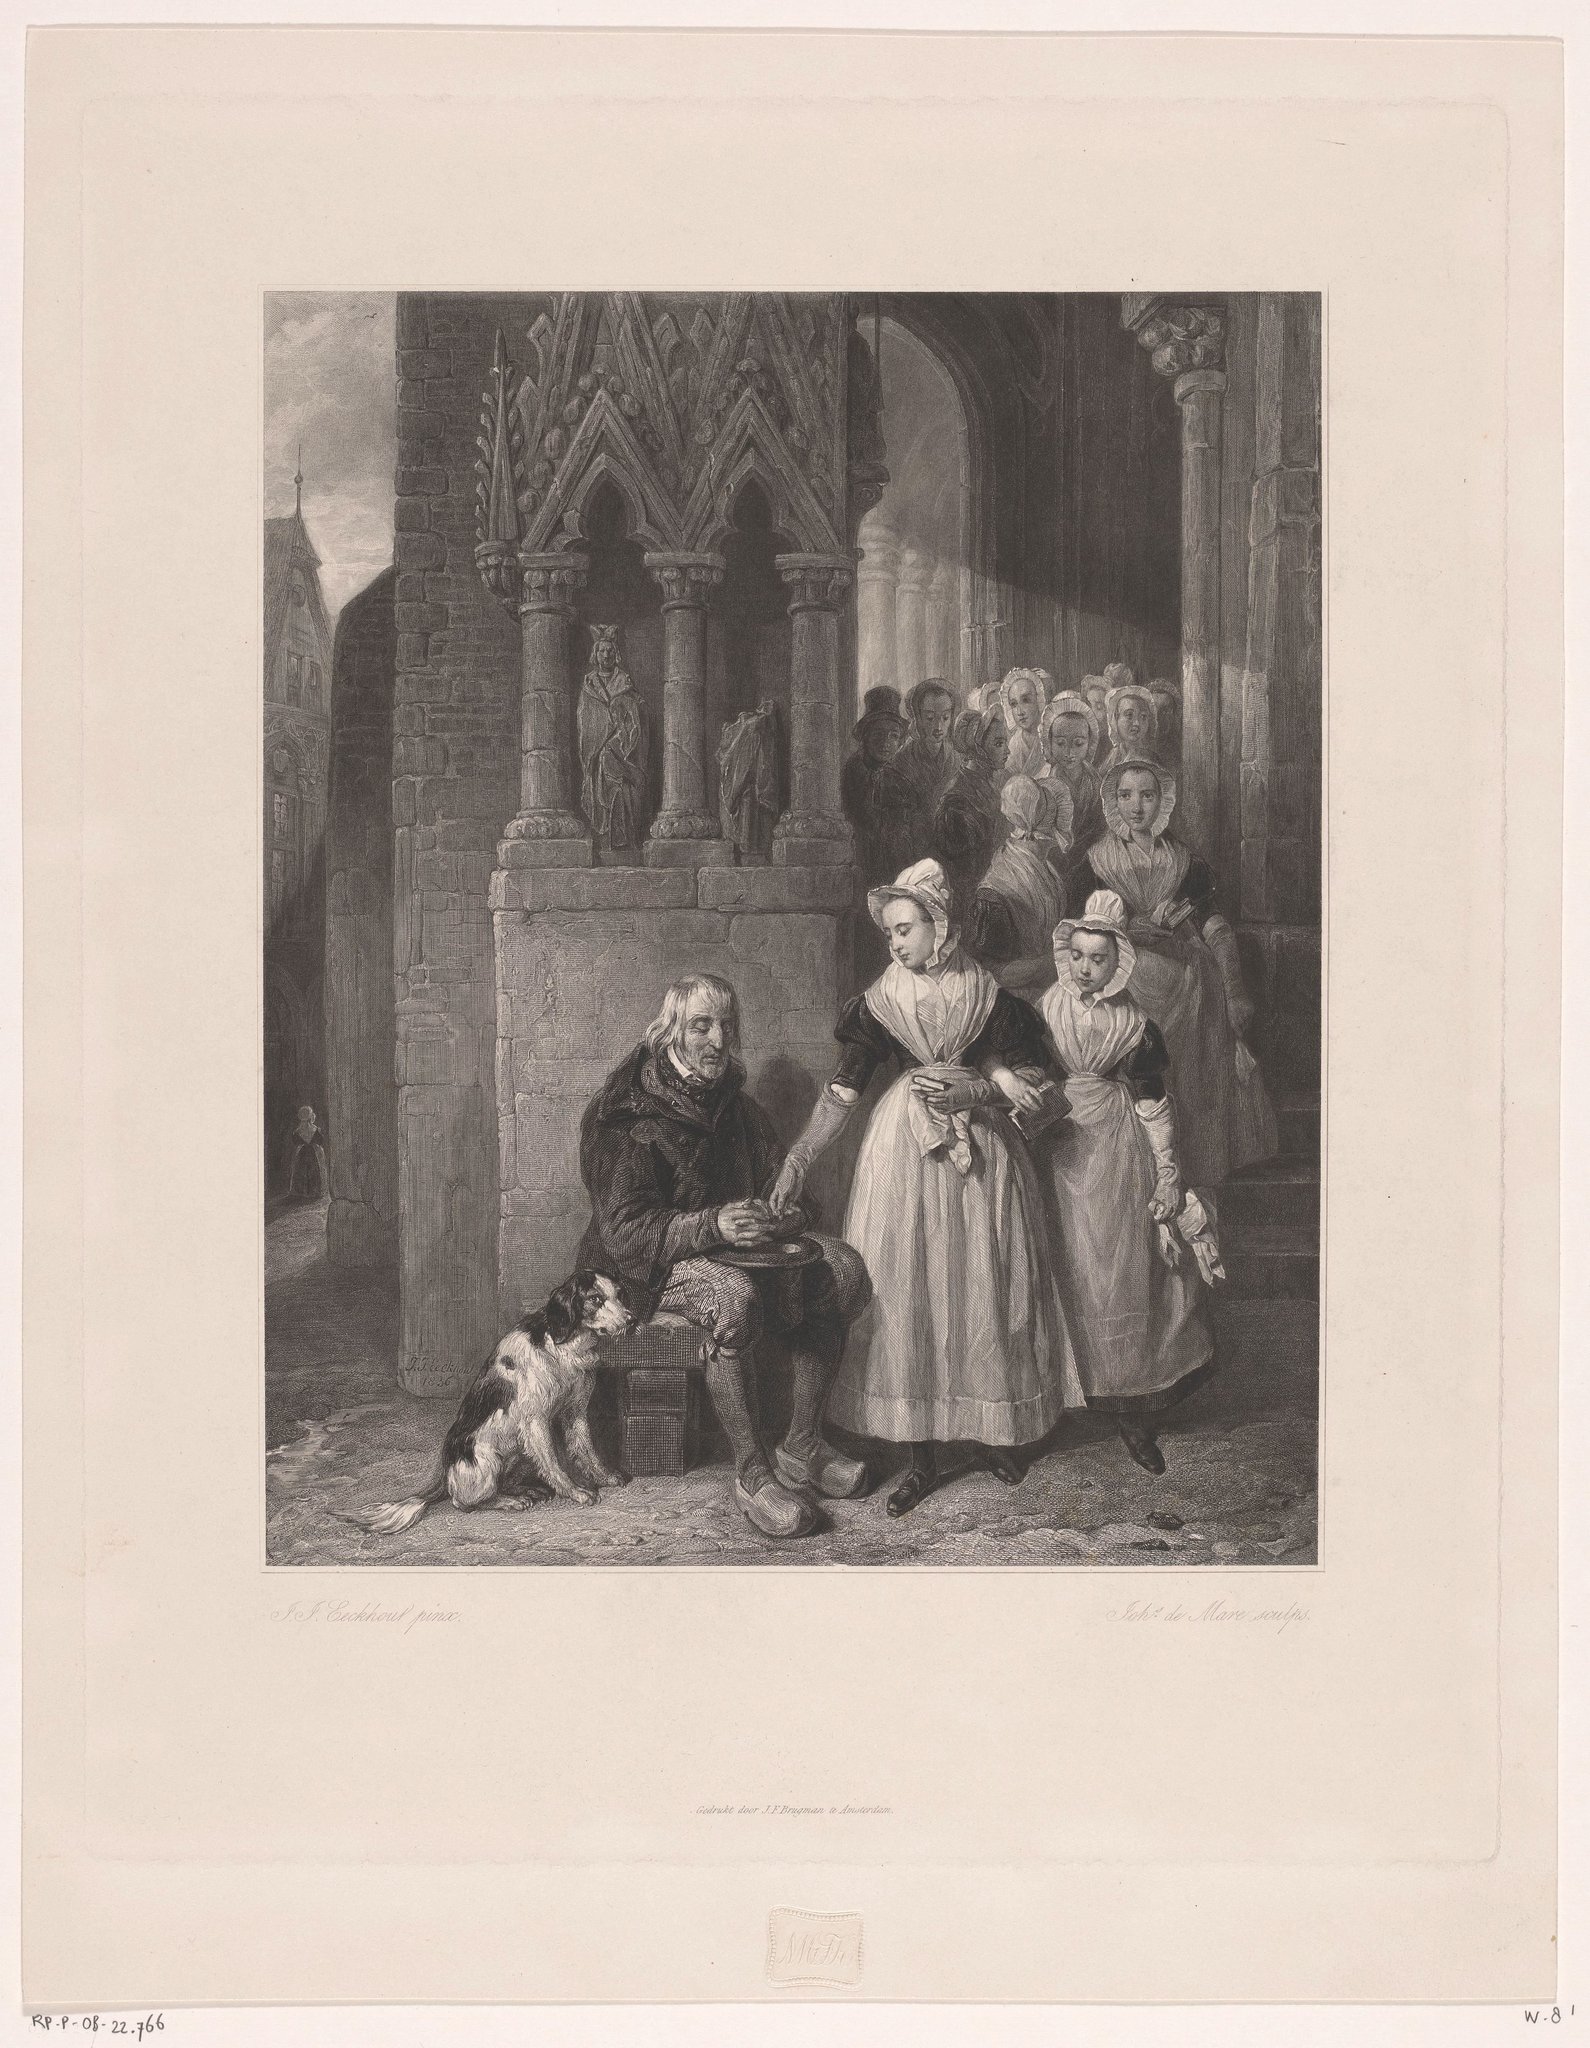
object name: print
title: Weesmeisje geeft aalmoes aan en bedelaar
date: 1850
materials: paper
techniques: engraving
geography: amsterdam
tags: parts of church exterior and annexes: portal, beggar, giving alms; collection, orphans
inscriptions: collector's mark: Lugt 12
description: Bij het uitgaan van een kerkmis lopen vele weesmeisjes door een kerkportaal. De voorste van hen geeft een aalmoes aan een bedelaar met naast hem een hond.